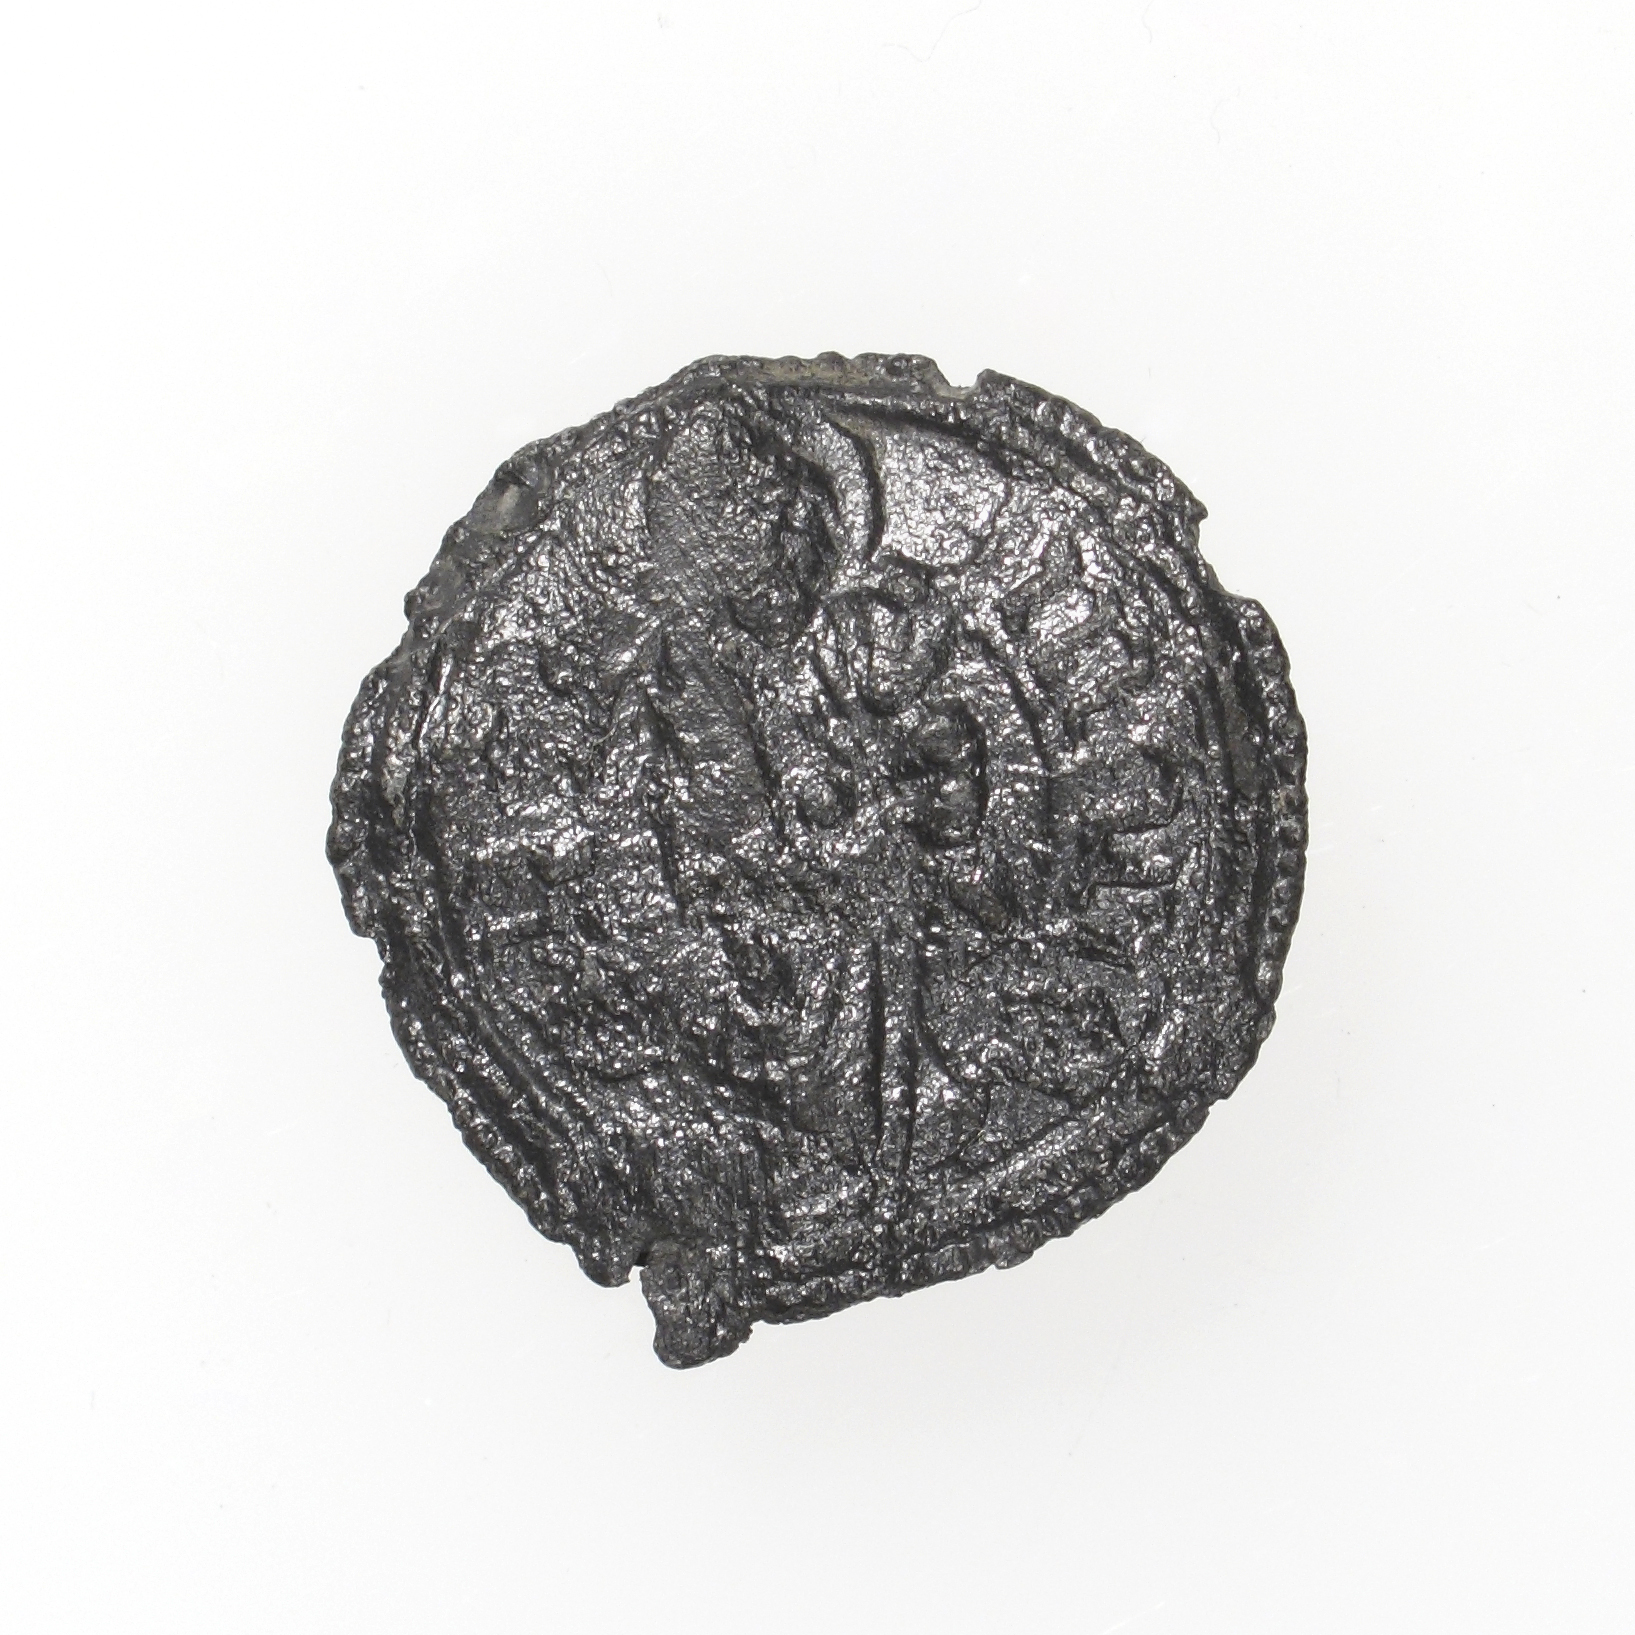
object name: pilgrim's badge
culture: french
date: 1301-1600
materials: lead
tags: madonna and child